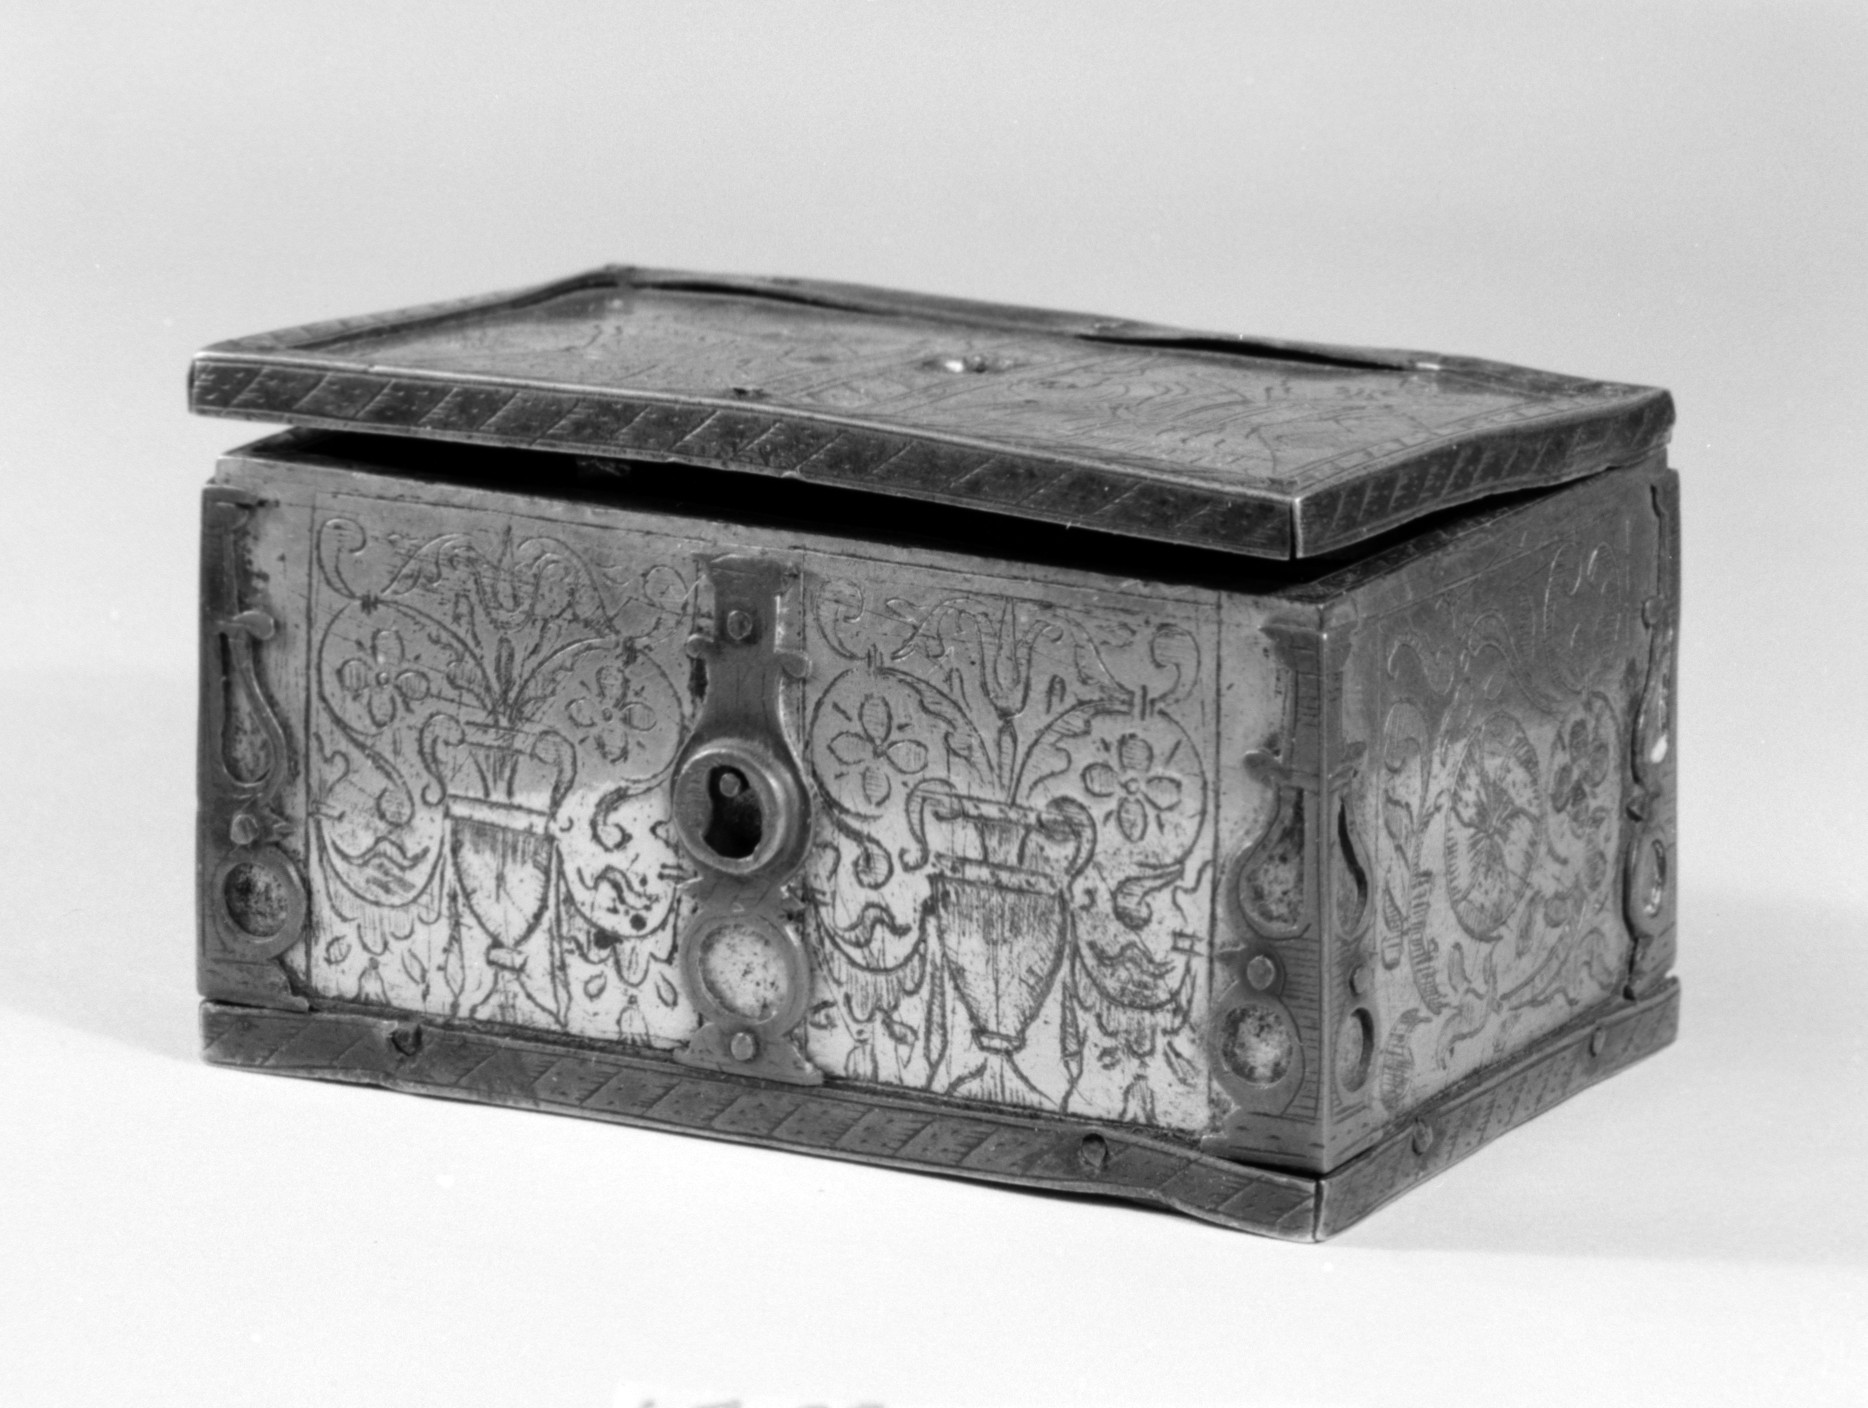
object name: coffret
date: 1601-1633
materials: brass, copper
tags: flowers